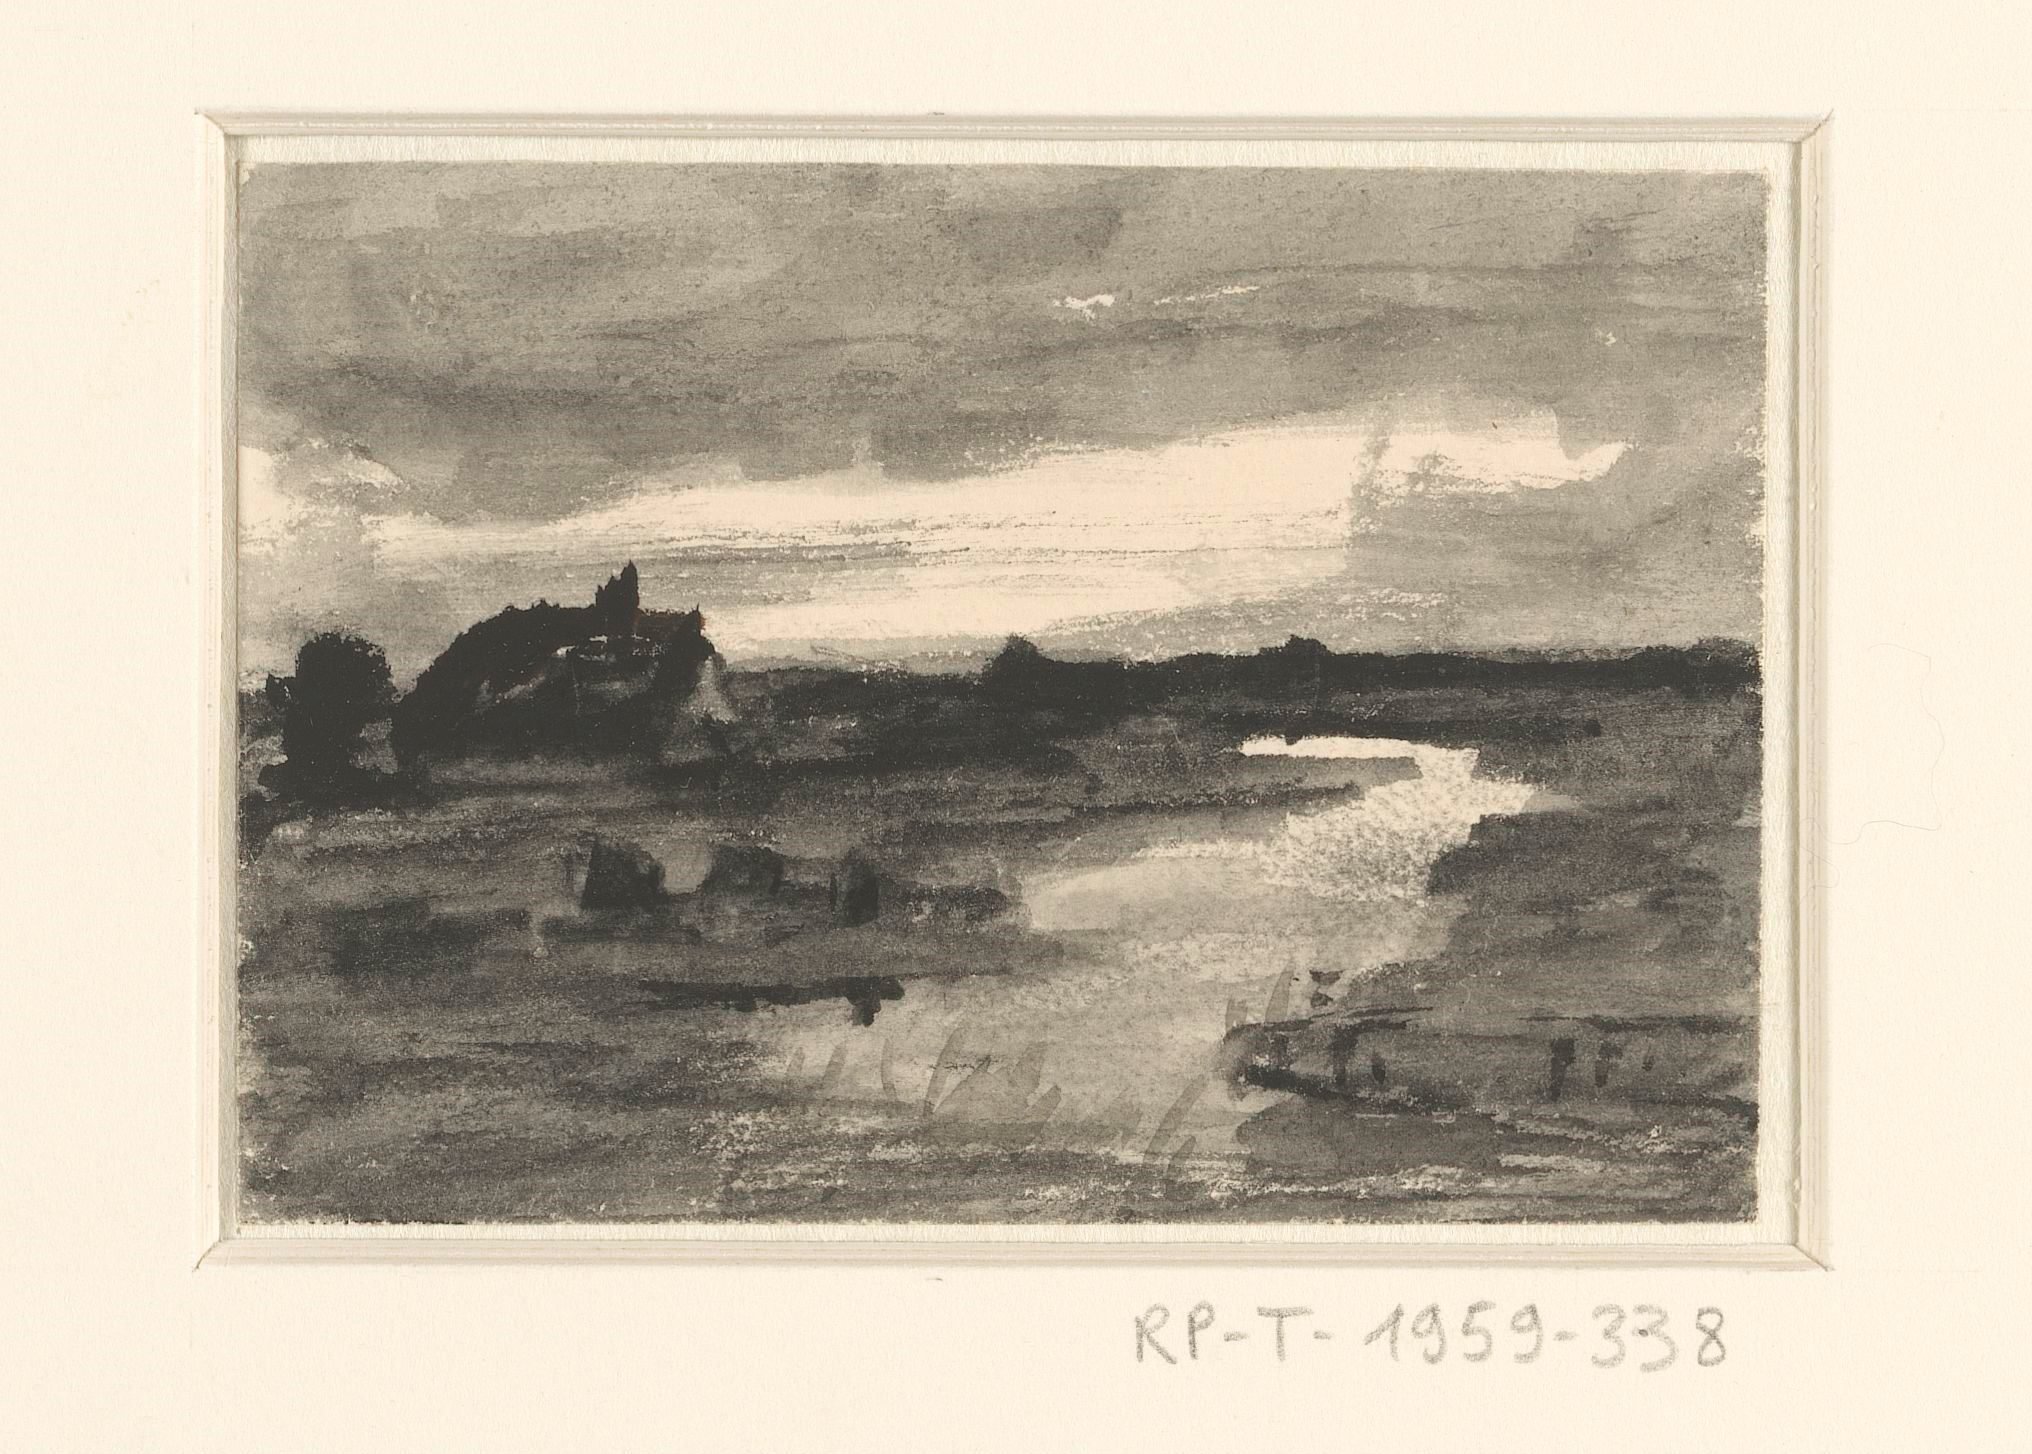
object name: drawing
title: Landschap met boerderij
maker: sientje mesdag-van houten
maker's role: draughtsman, painter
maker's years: 1834-1909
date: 1844-1909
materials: paper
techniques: brush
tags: farm or solitary house in landscape